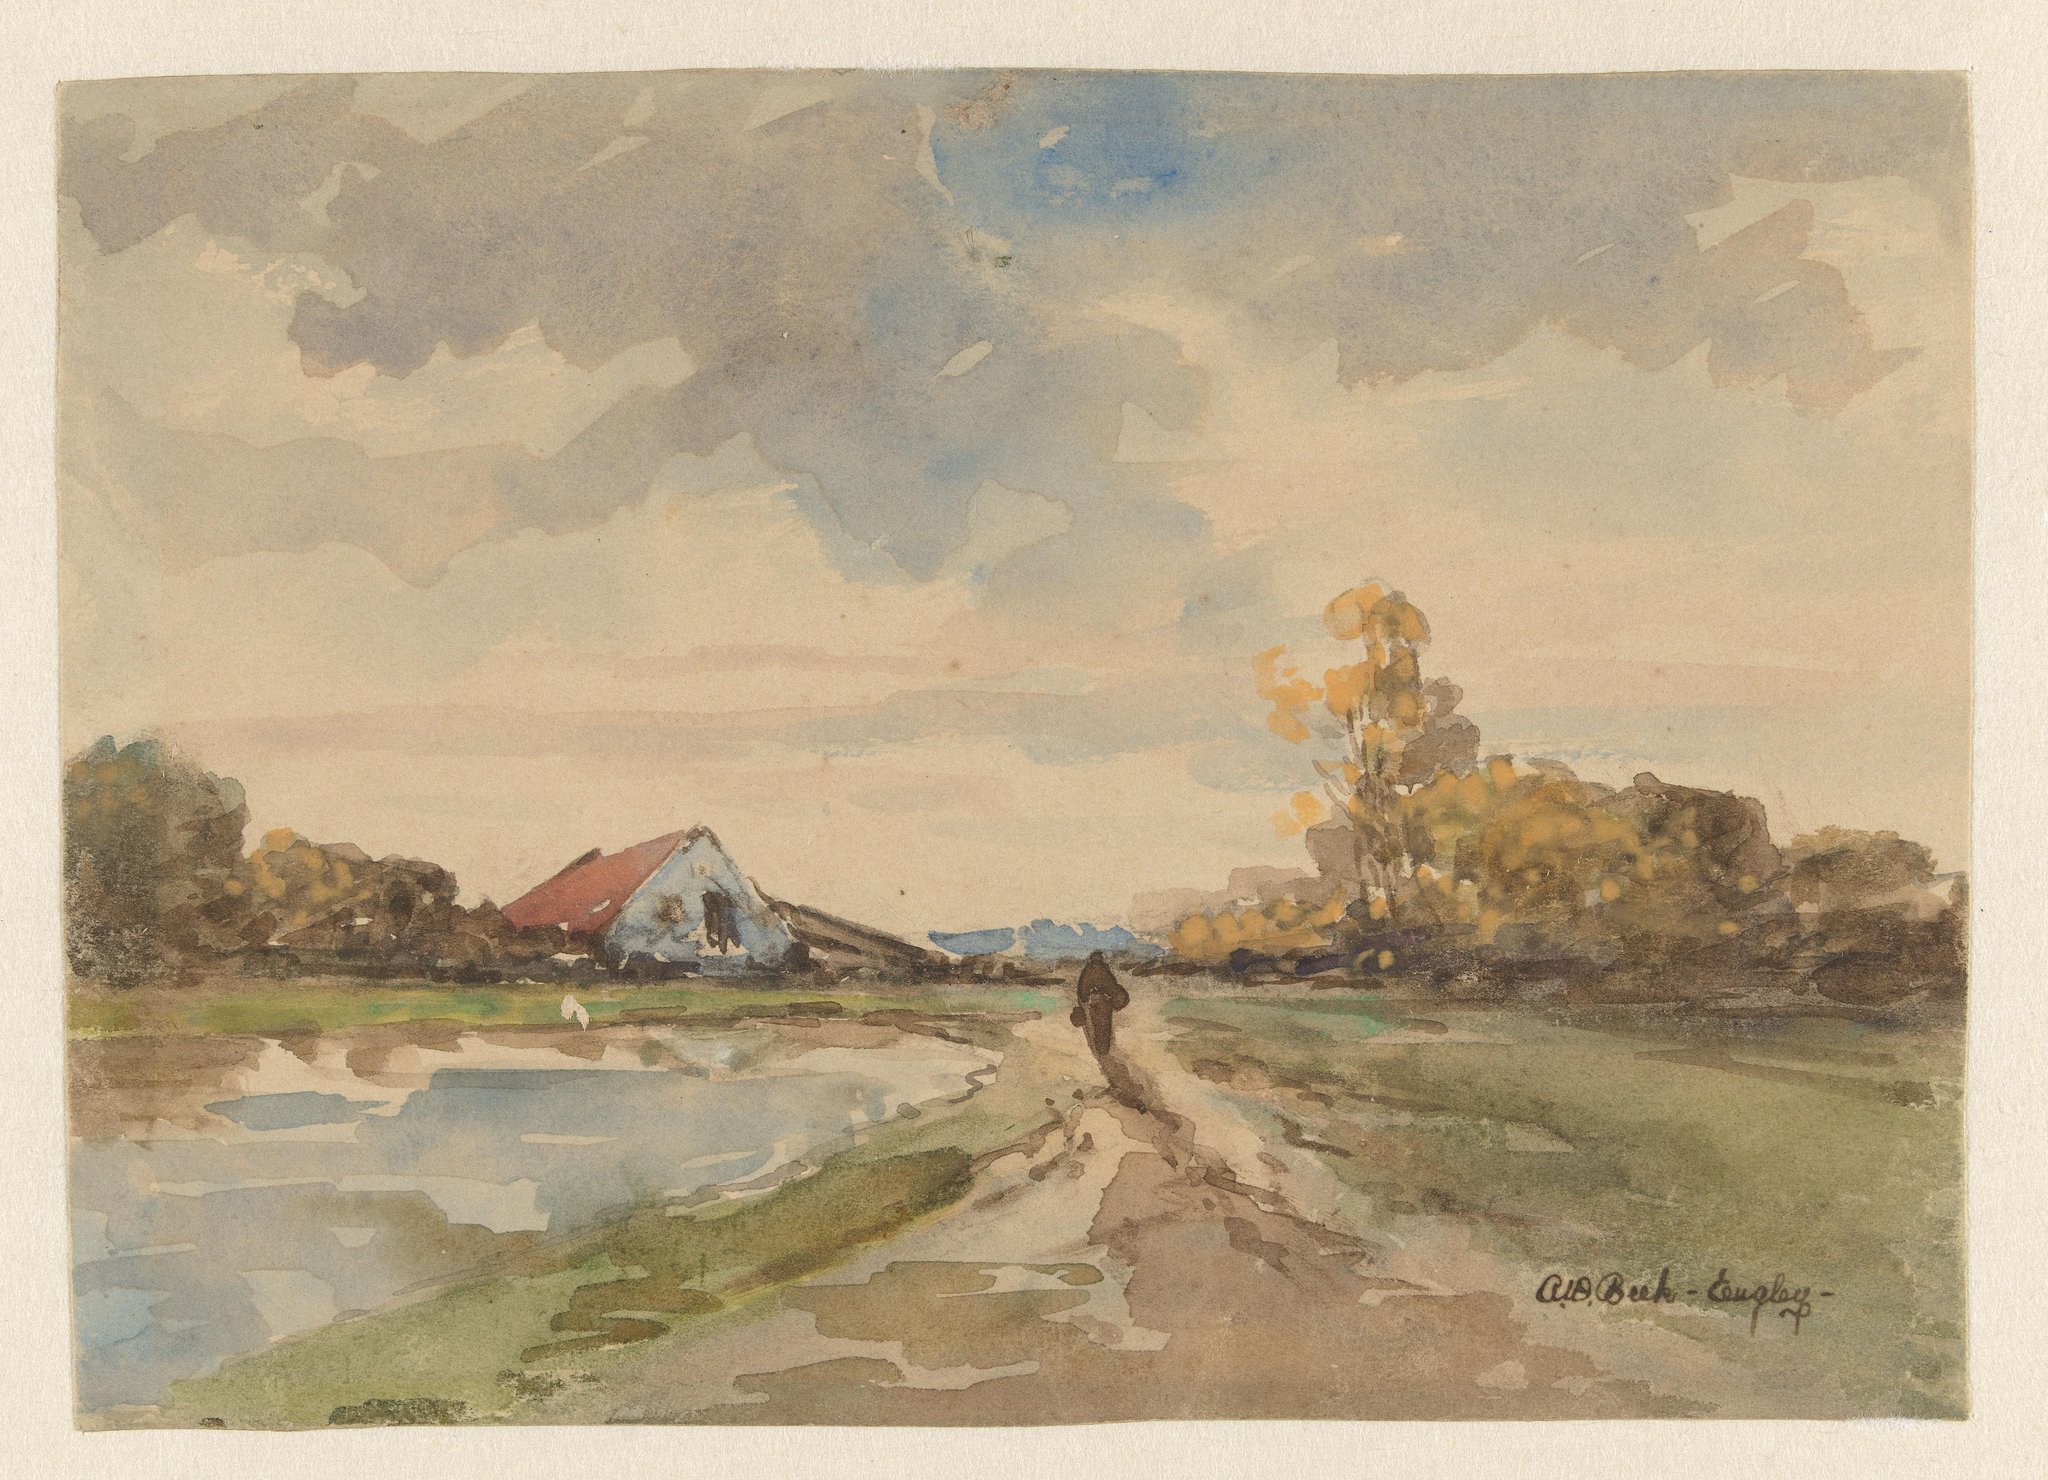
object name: drawing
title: Landschap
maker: beek - tengley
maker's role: draughtsman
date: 1800-1900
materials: paper, watercolor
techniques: brush